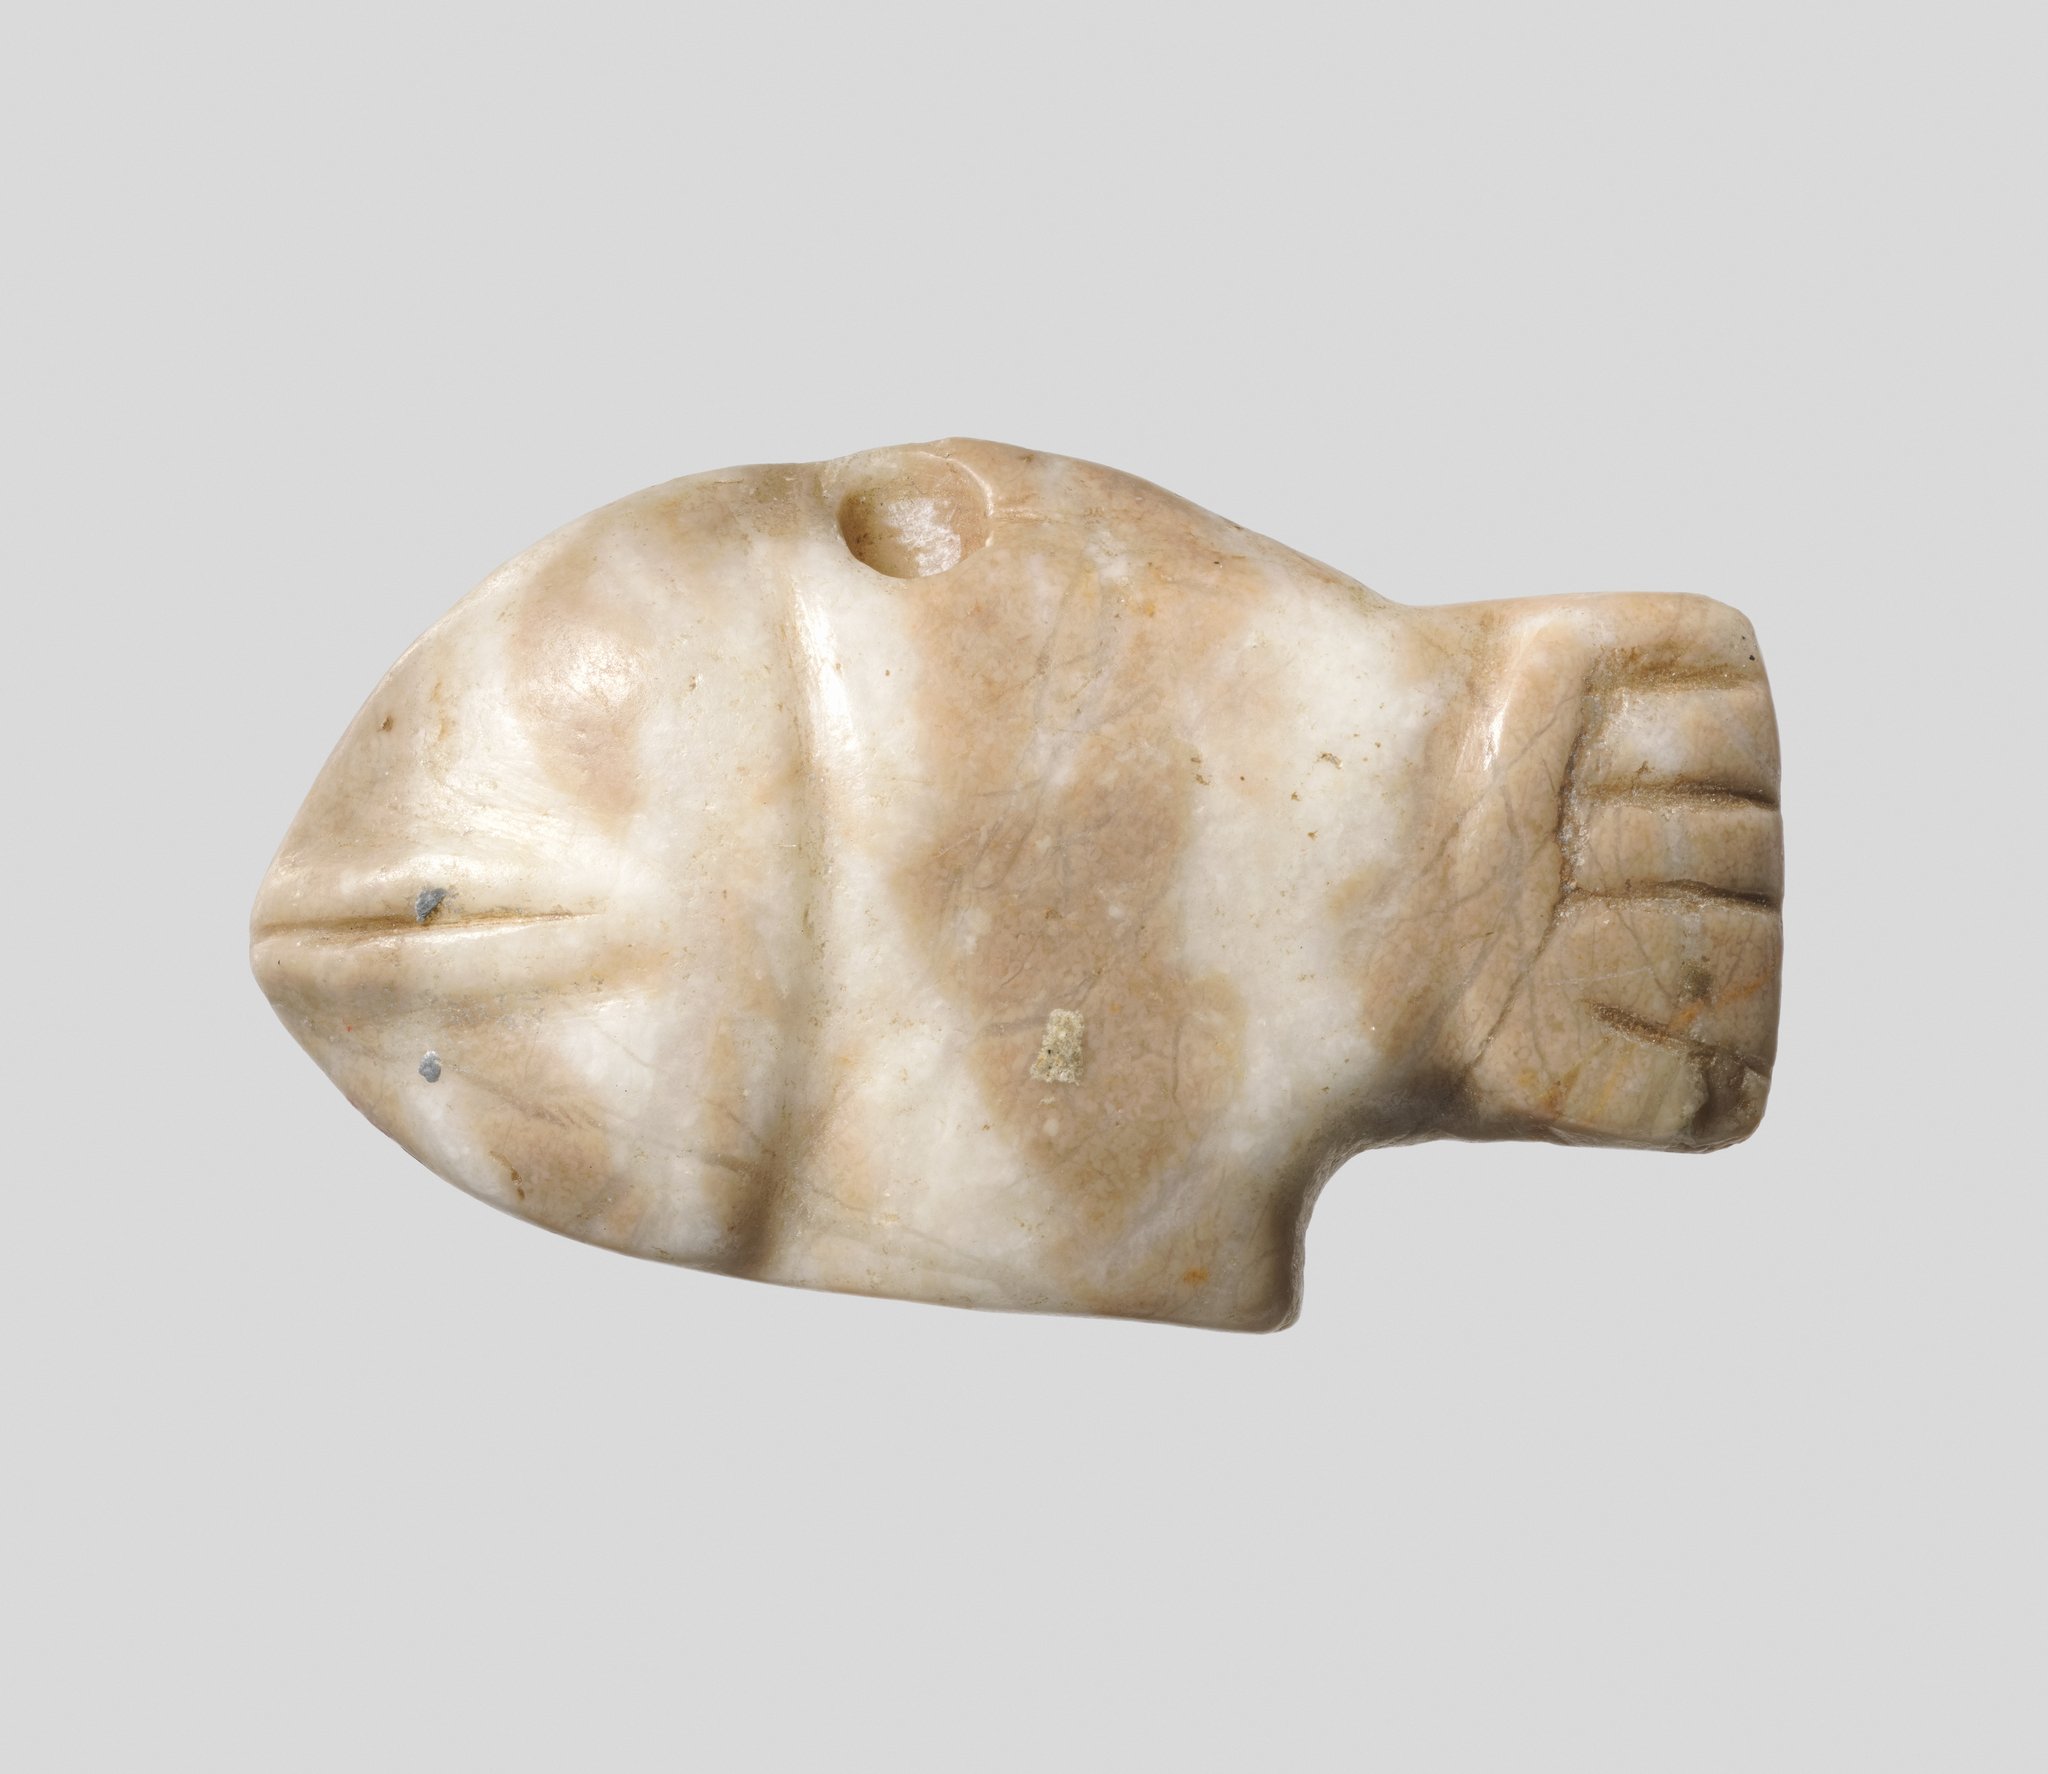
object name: stamp seal amulet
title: Seal amulet in the form of a fish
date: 3500-2900 BCE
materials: marble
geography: mesopotamia or syria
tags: fish